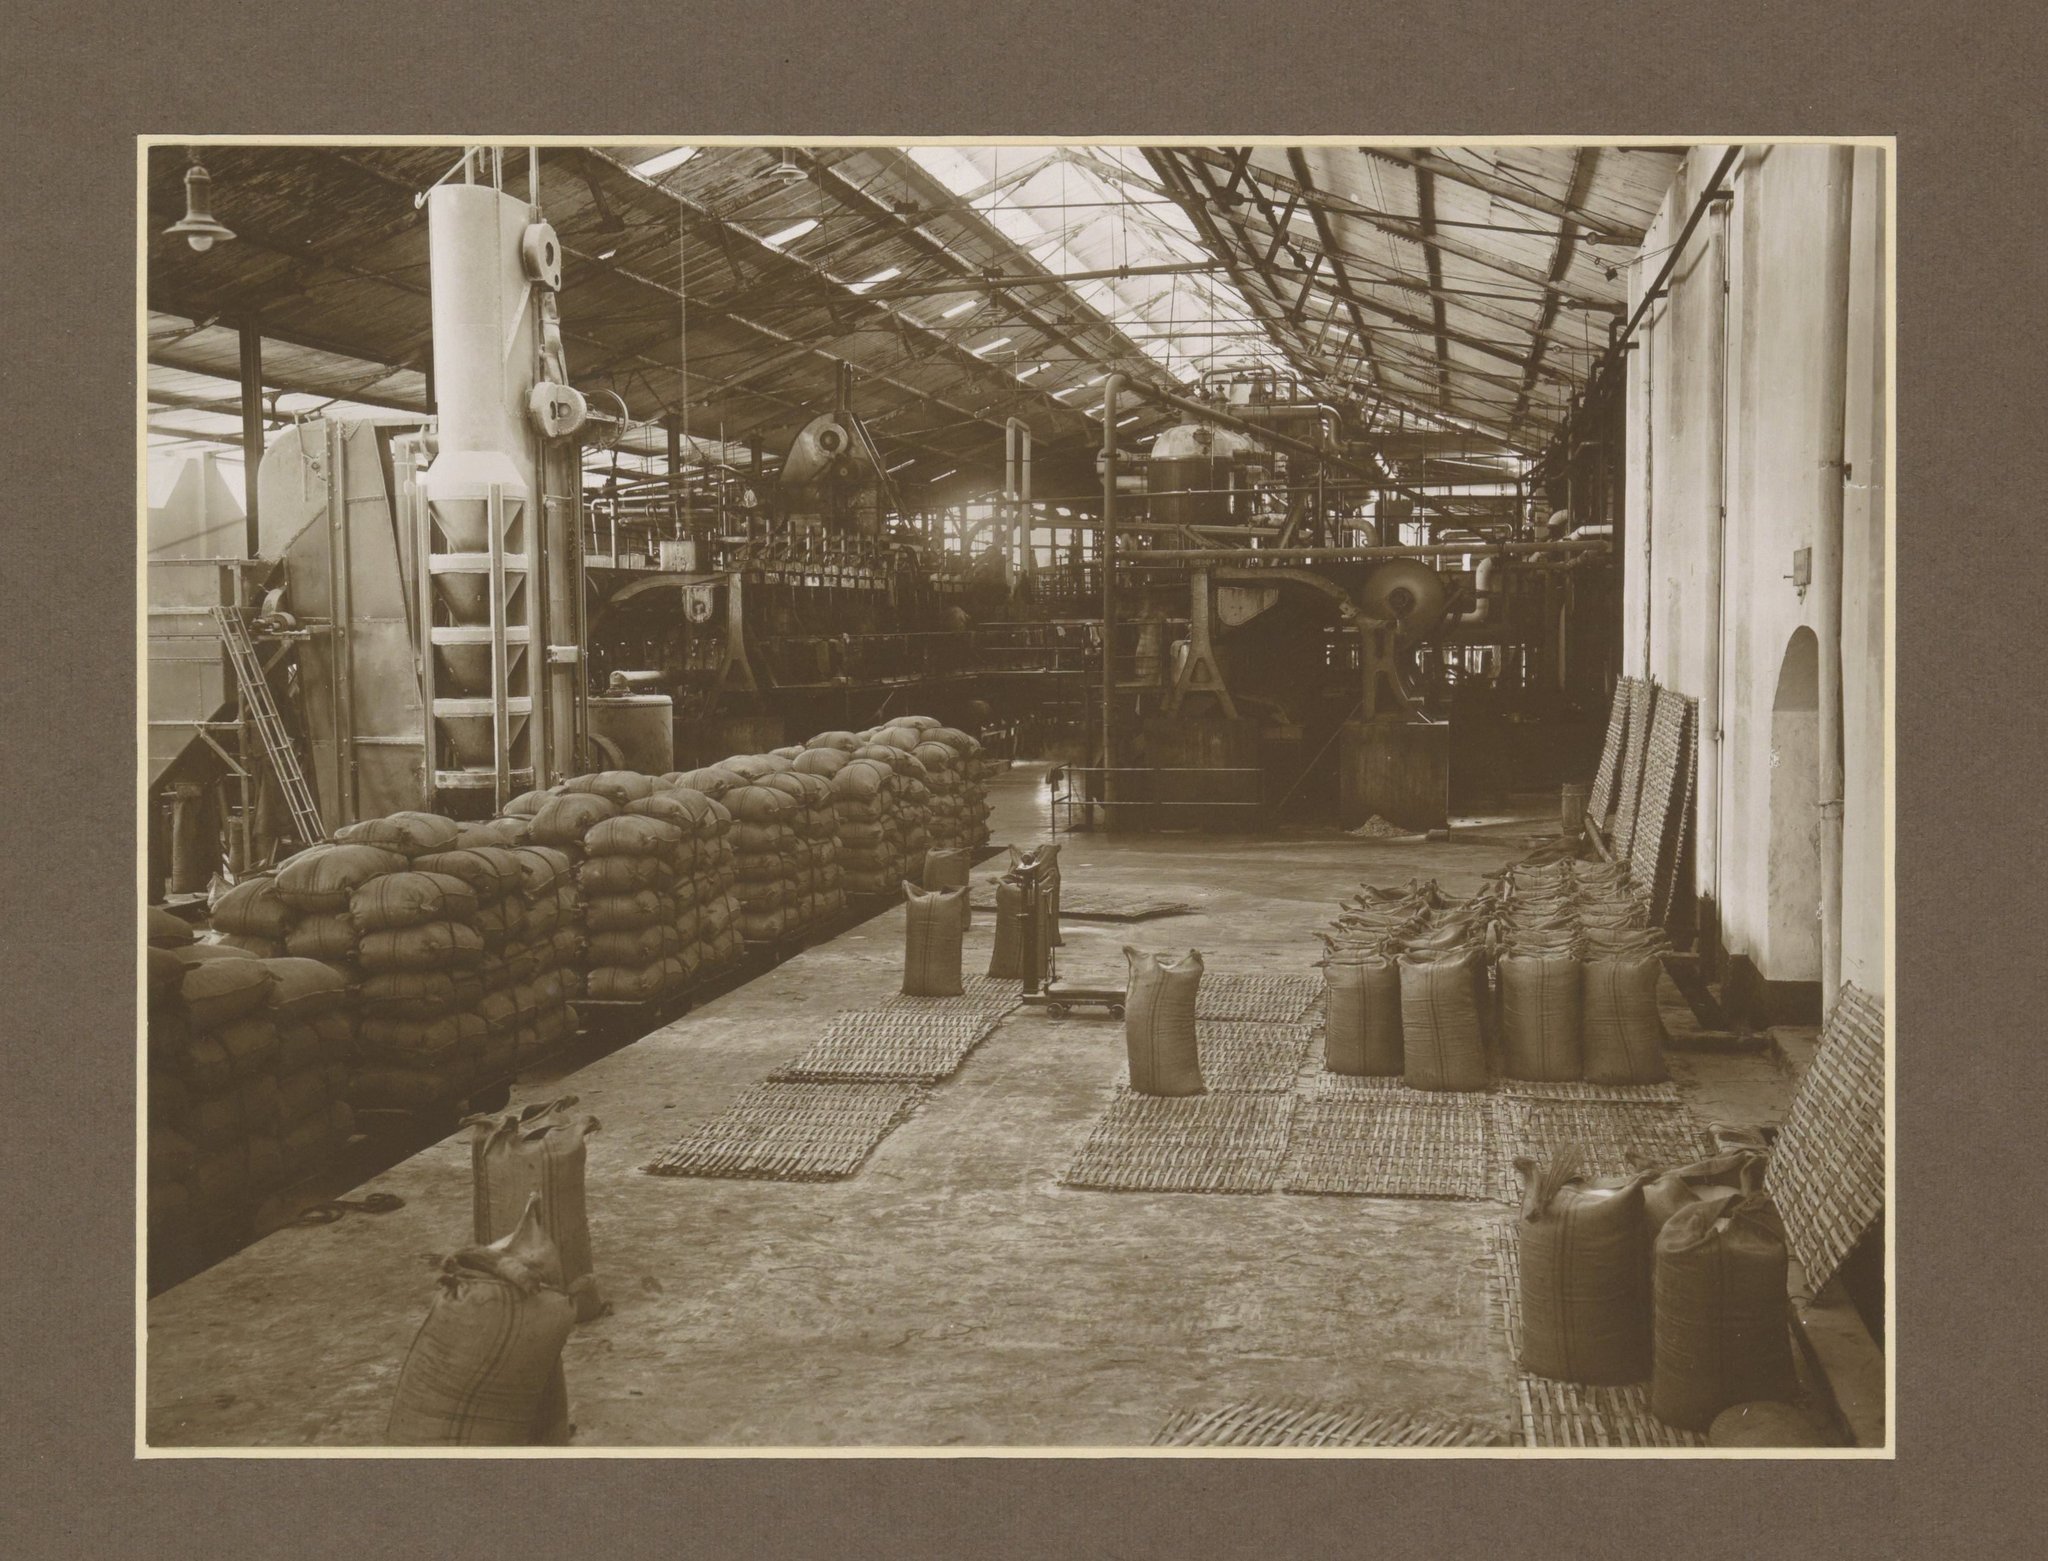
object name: album leaf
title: Centrifugehuis van suikerfabriek Meritjan te Kediri op Java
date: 1925-1930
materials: cardboard, paper, photographic support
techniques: gelatin silver print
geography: kediri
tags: plantation, factory-interior, machine shop, storing in sacks ~ harvest, plants and herbs: sugarcane, sugar, dutch east indies, the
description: Onderdeel van Fotoalbum met opnames van vier suikerfabrieken op Java.